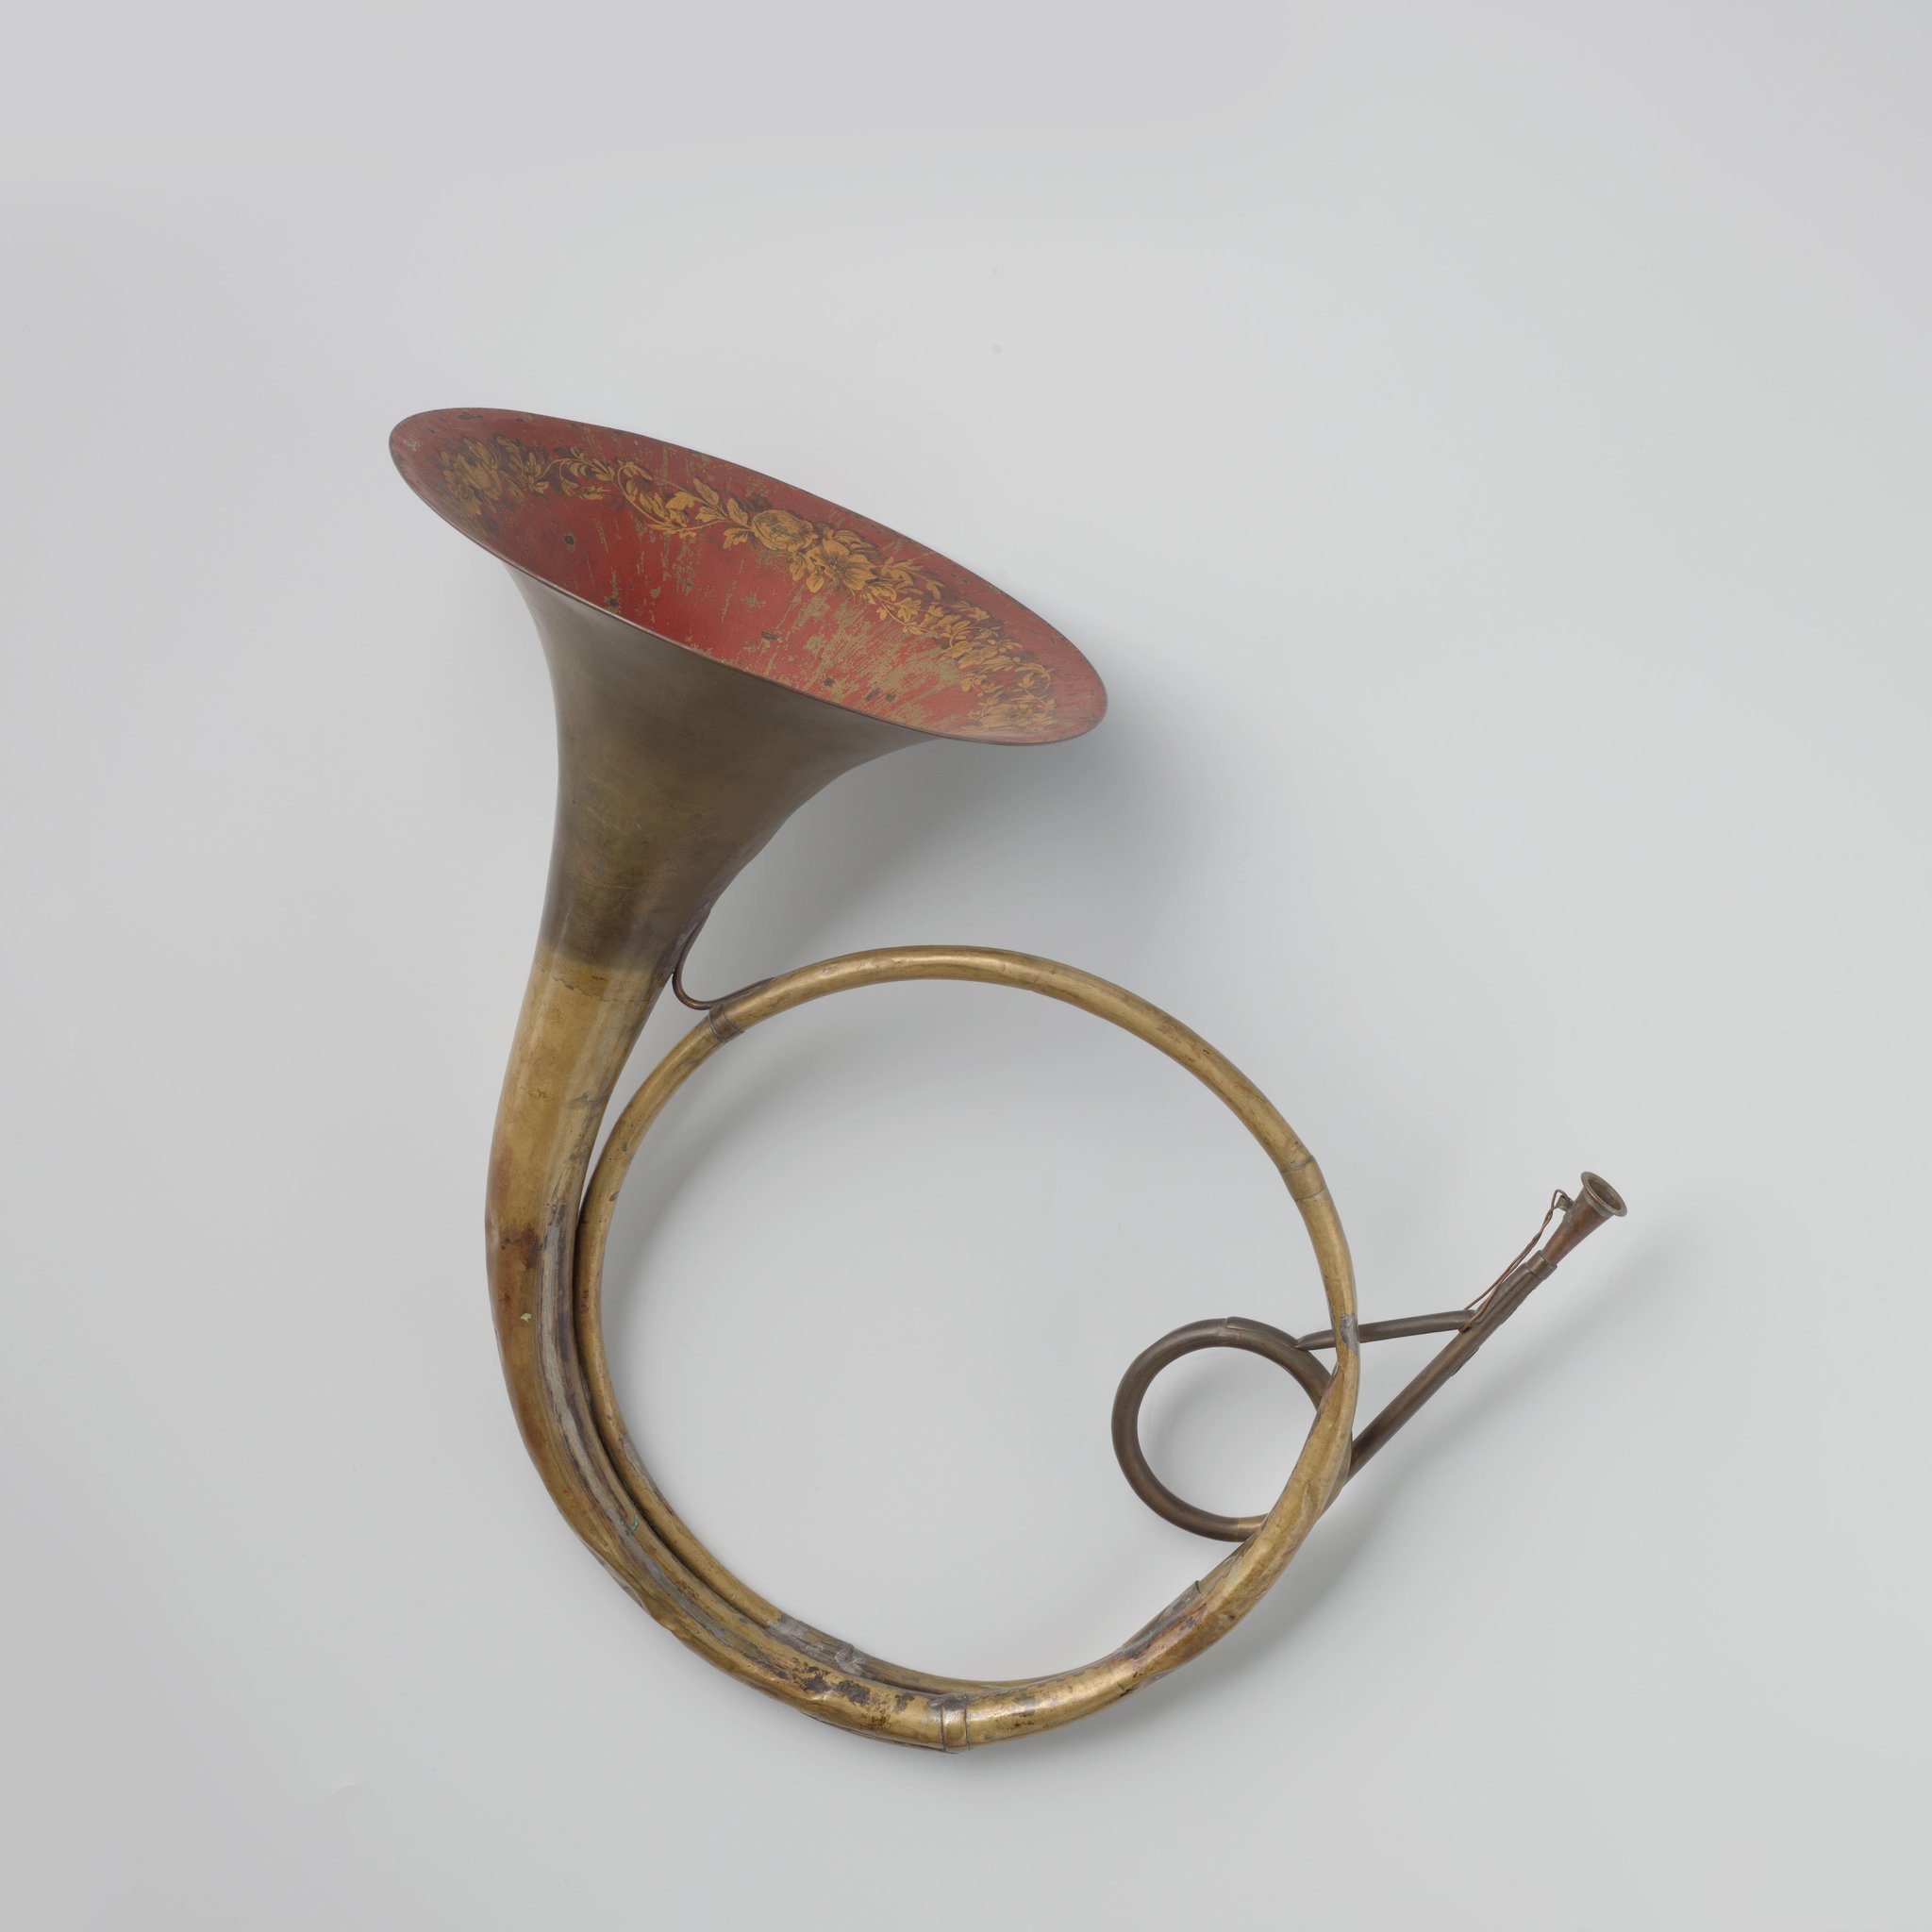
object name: horn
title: Natural horn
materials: copper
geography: lierre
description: Op de beker gegraveerd 'G. van Engelen / ainé à Lierre'. De bekermond is rood gelakt. Daarop zijn met goudverf blad- en bloemmotieven geschilderd. Met groen koord omwonden.